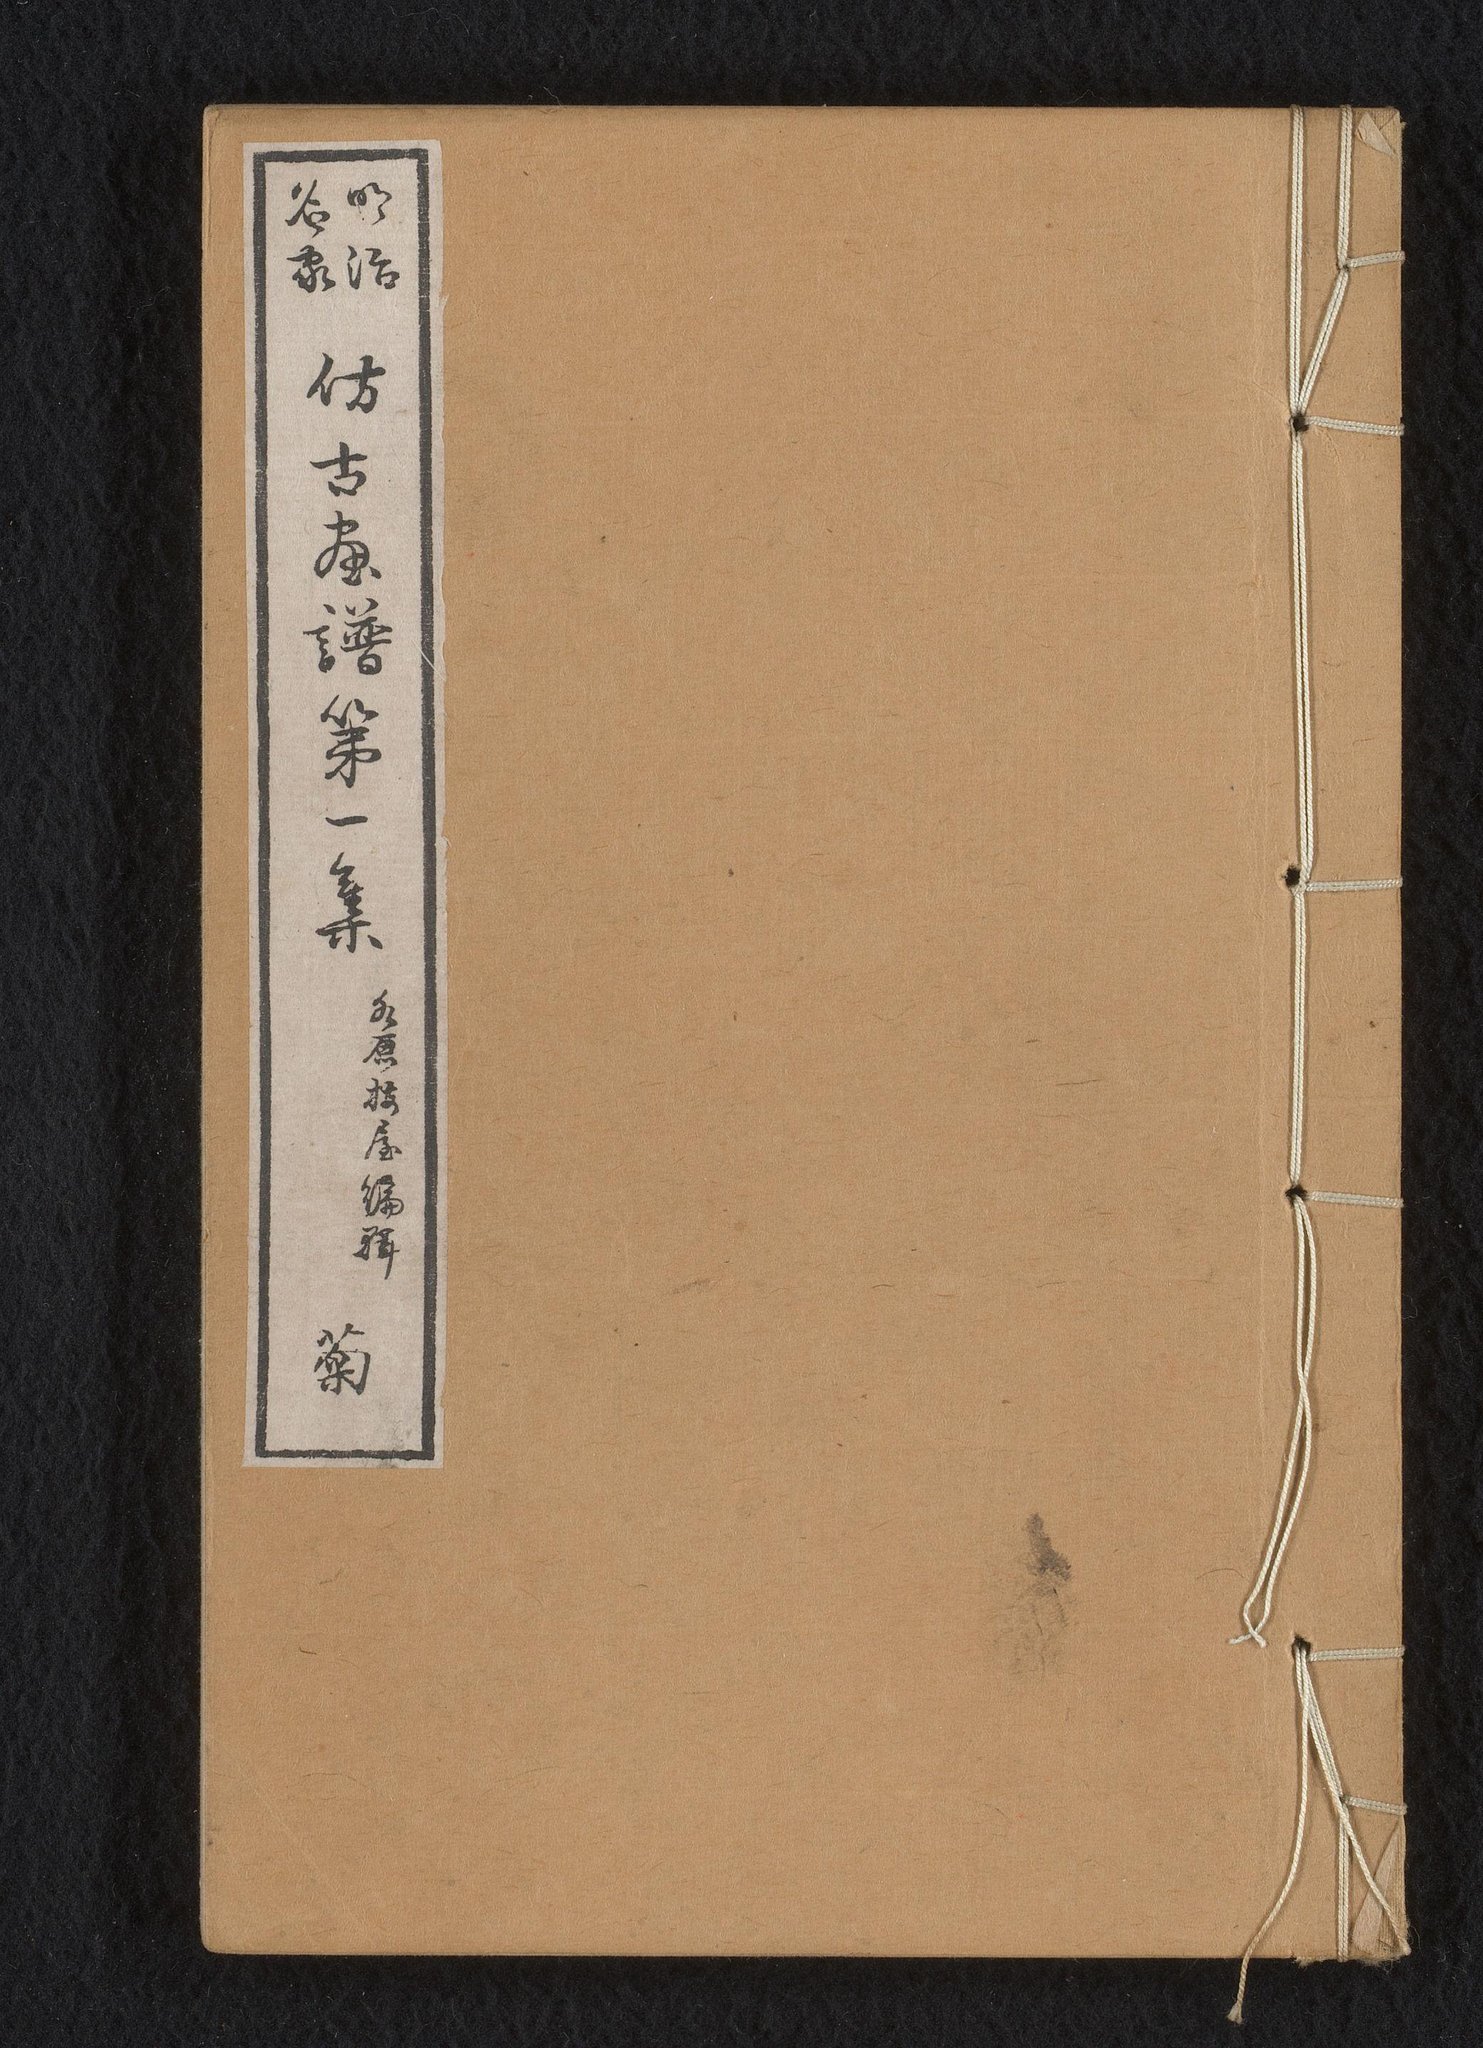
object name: book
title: Chrysanten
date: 1880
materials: paper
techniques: woodcut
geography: osaka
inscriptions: date